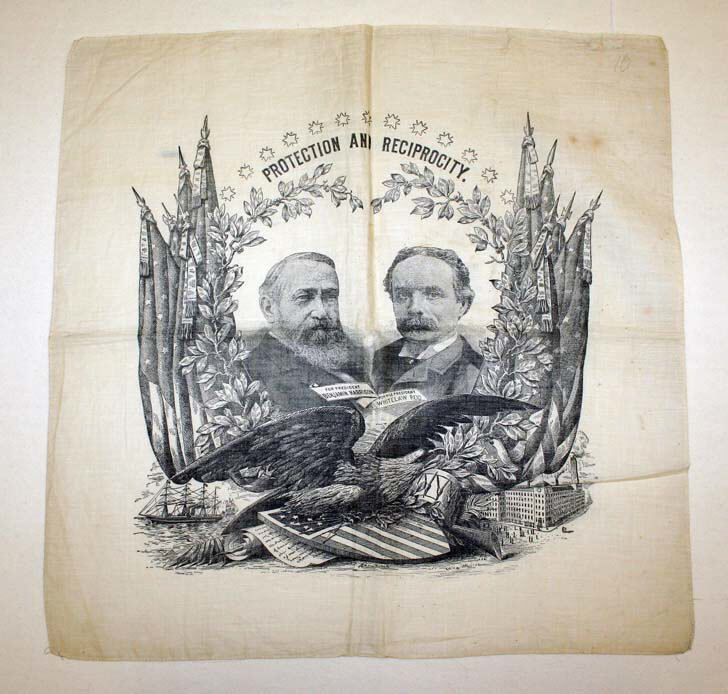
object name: handkerchief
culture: american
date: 1889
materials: cotton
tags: elections,men,portraits,politics